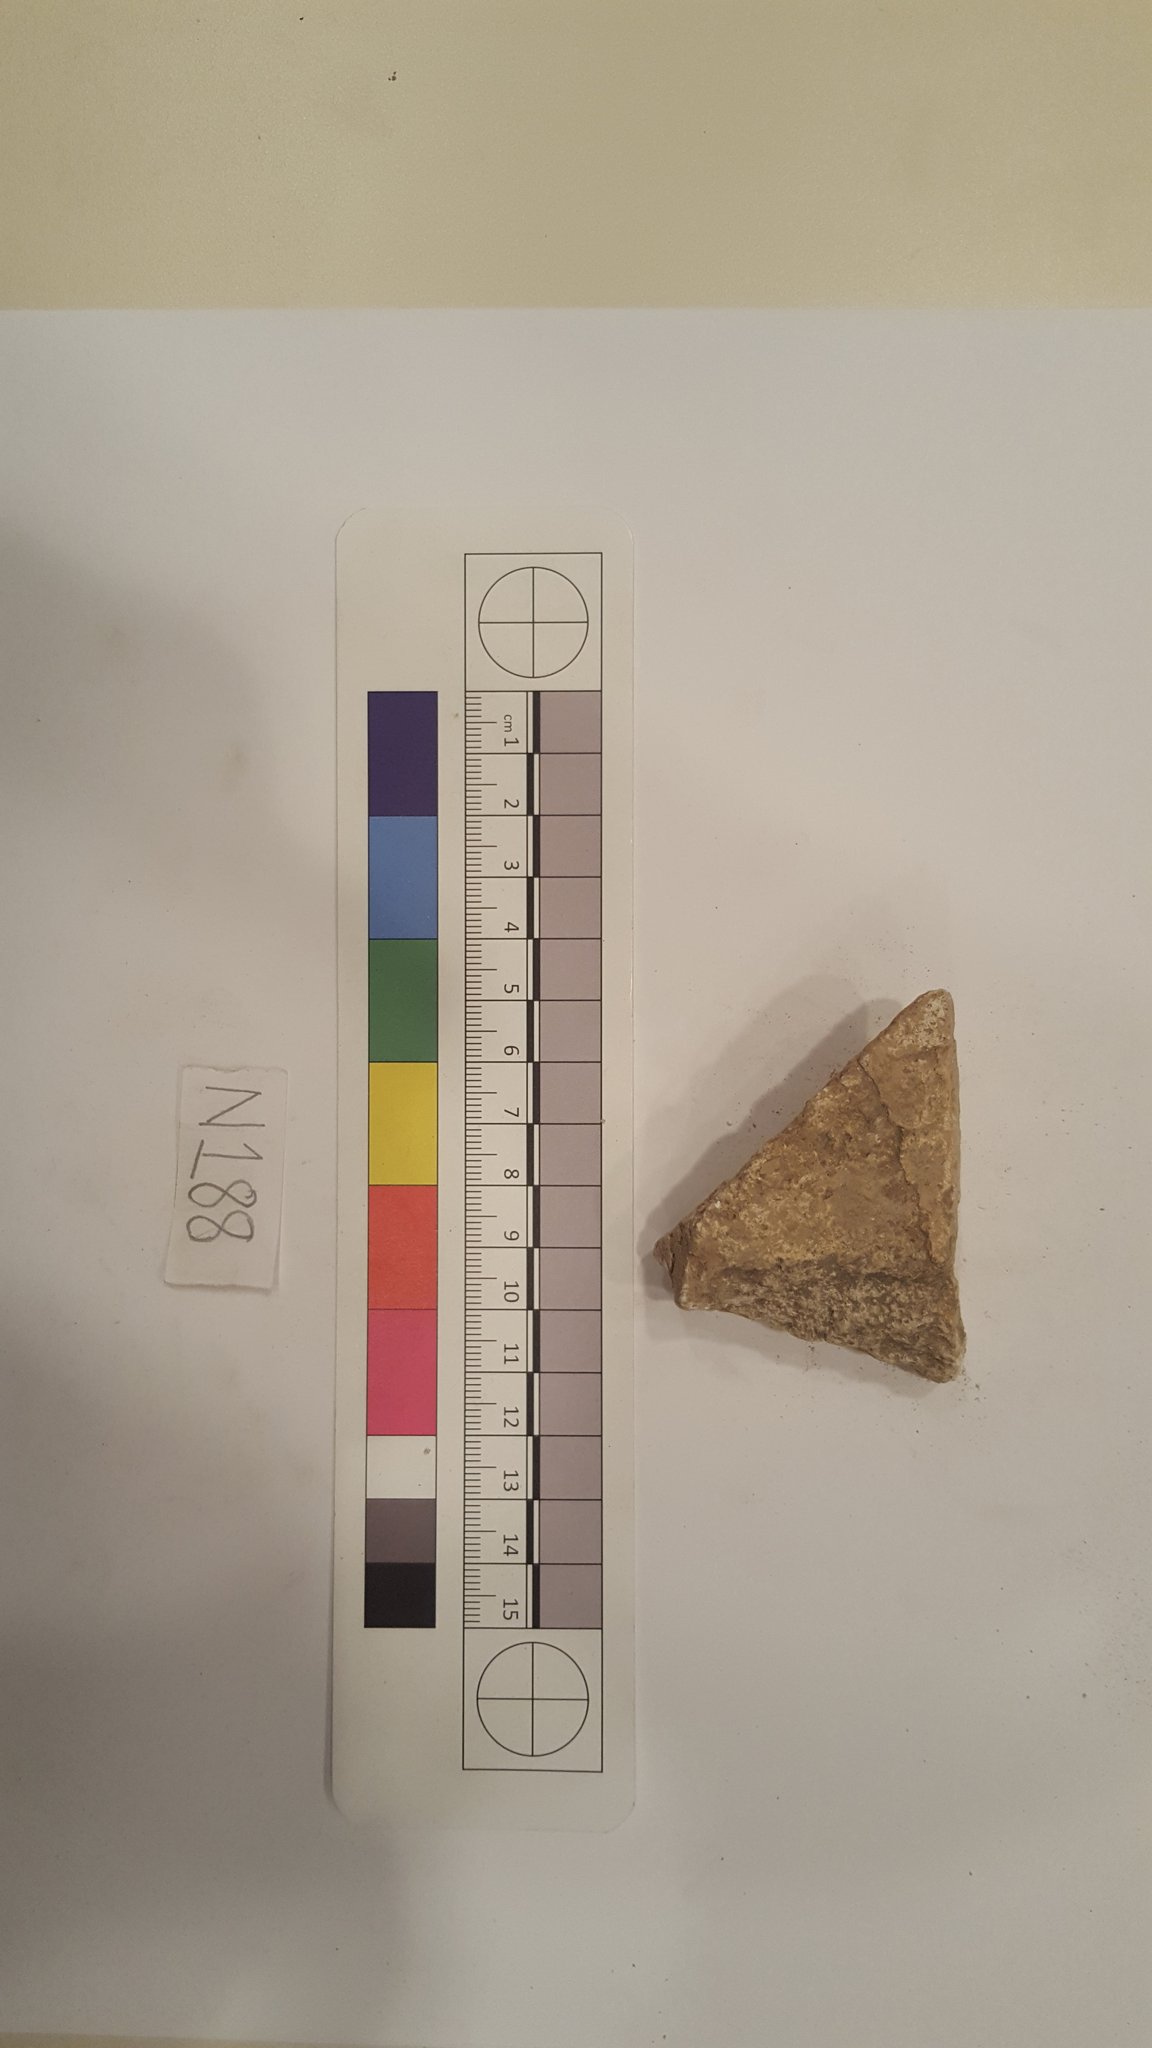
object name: fragment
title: Stucco Fragment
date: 701-1200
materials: plaster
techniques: carving, painting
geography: iran